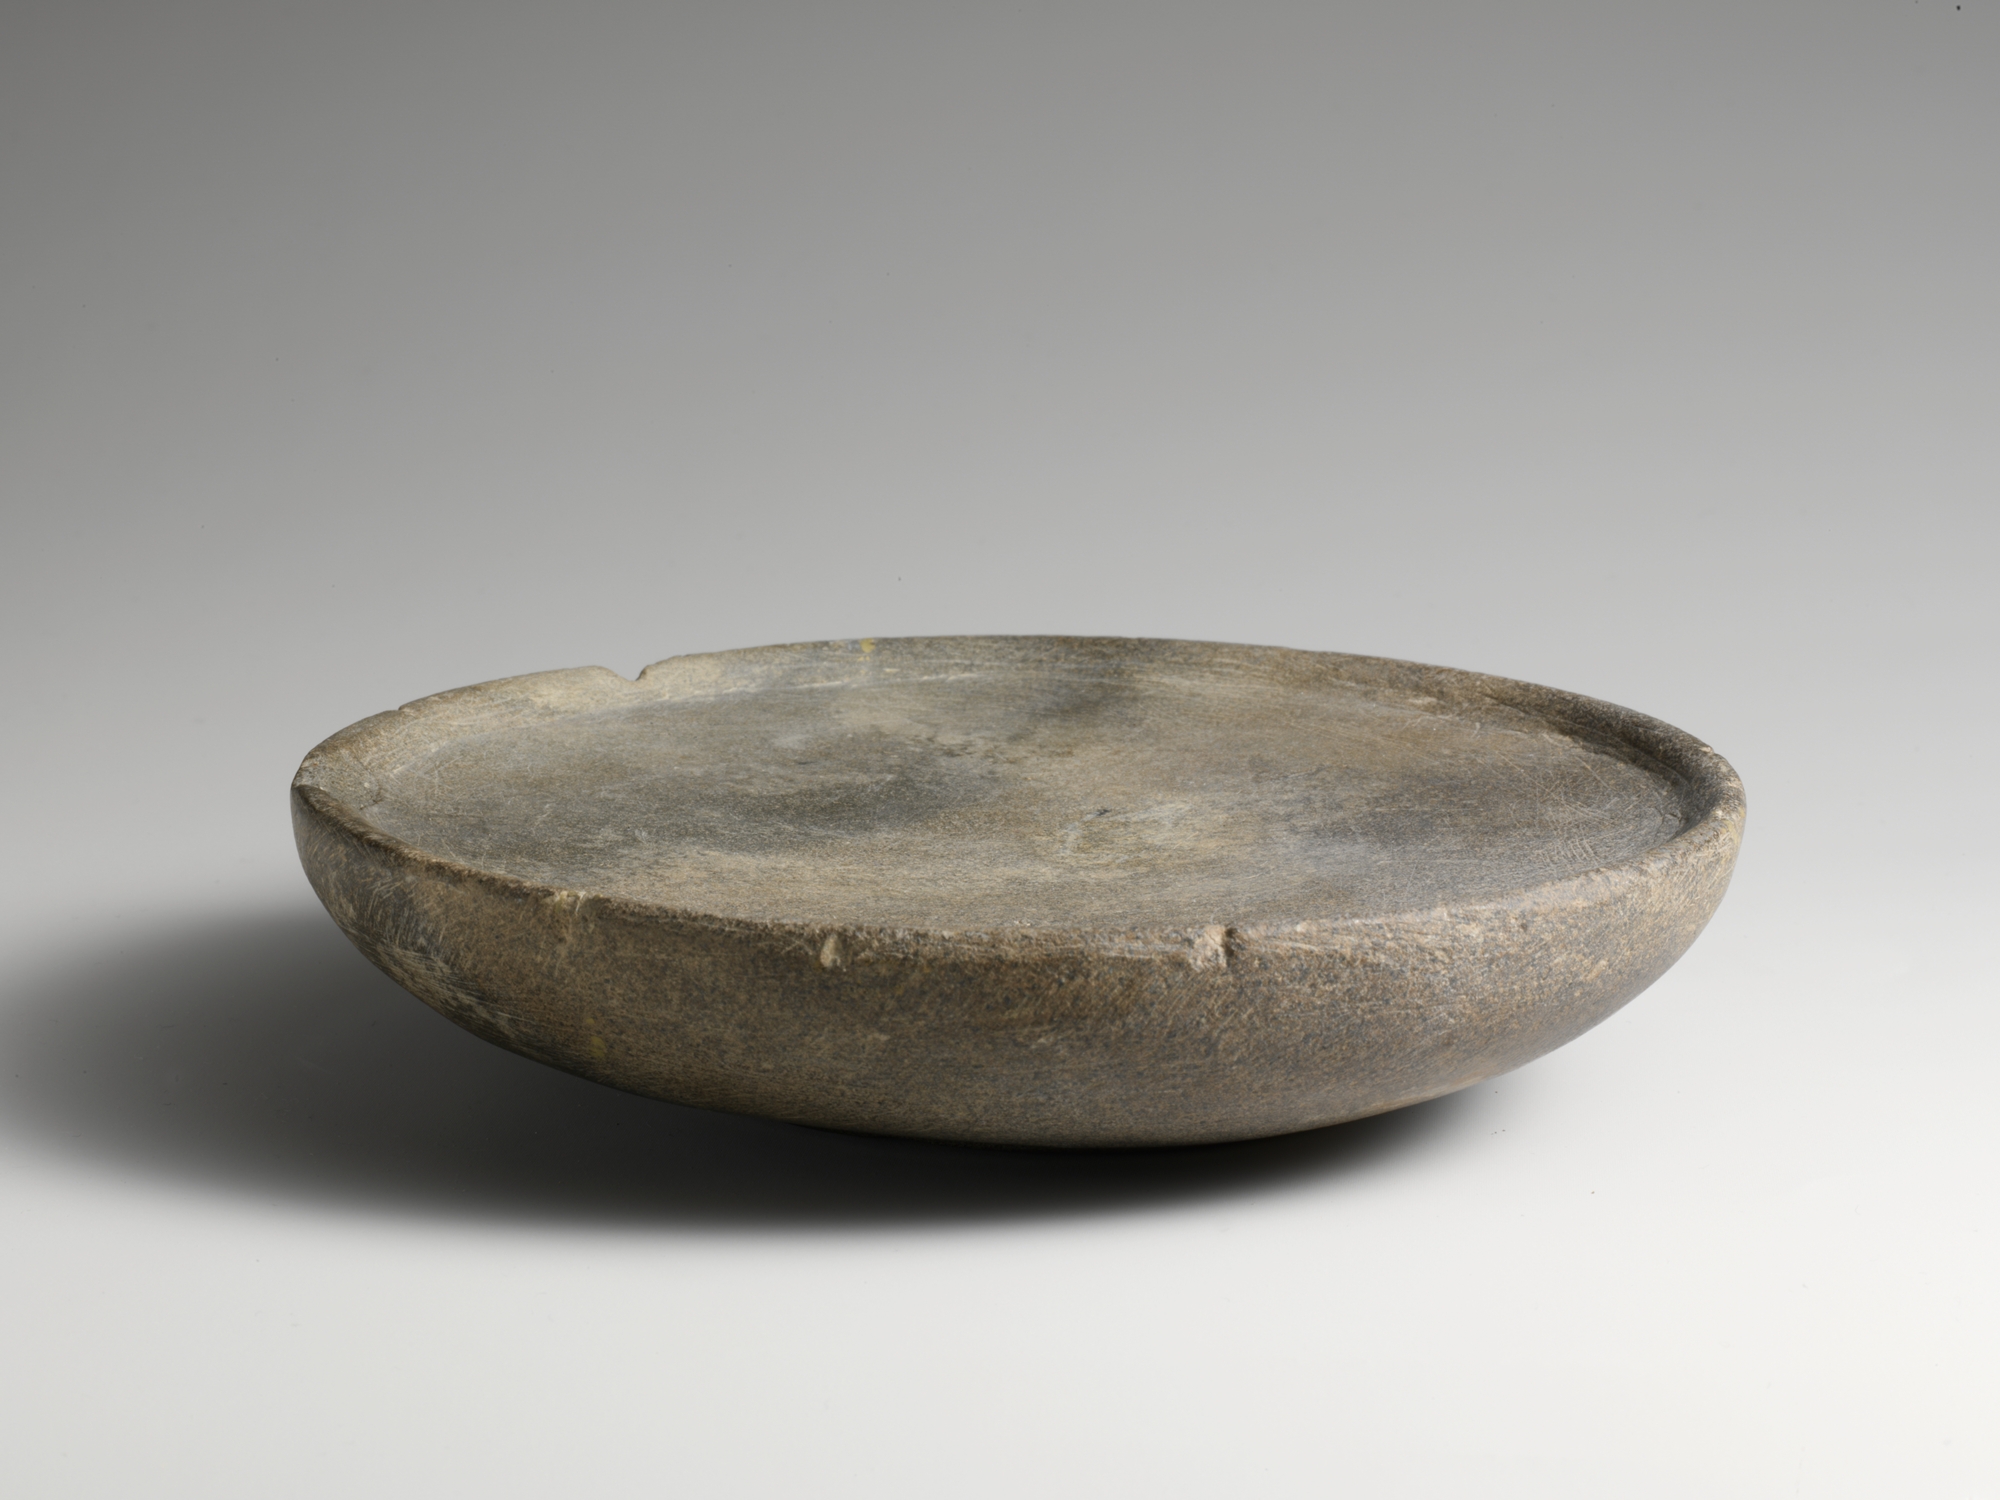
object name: plate or palette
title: Chlorite mortar or plate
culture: cypriot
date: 1200-1050 BCE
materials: mineral